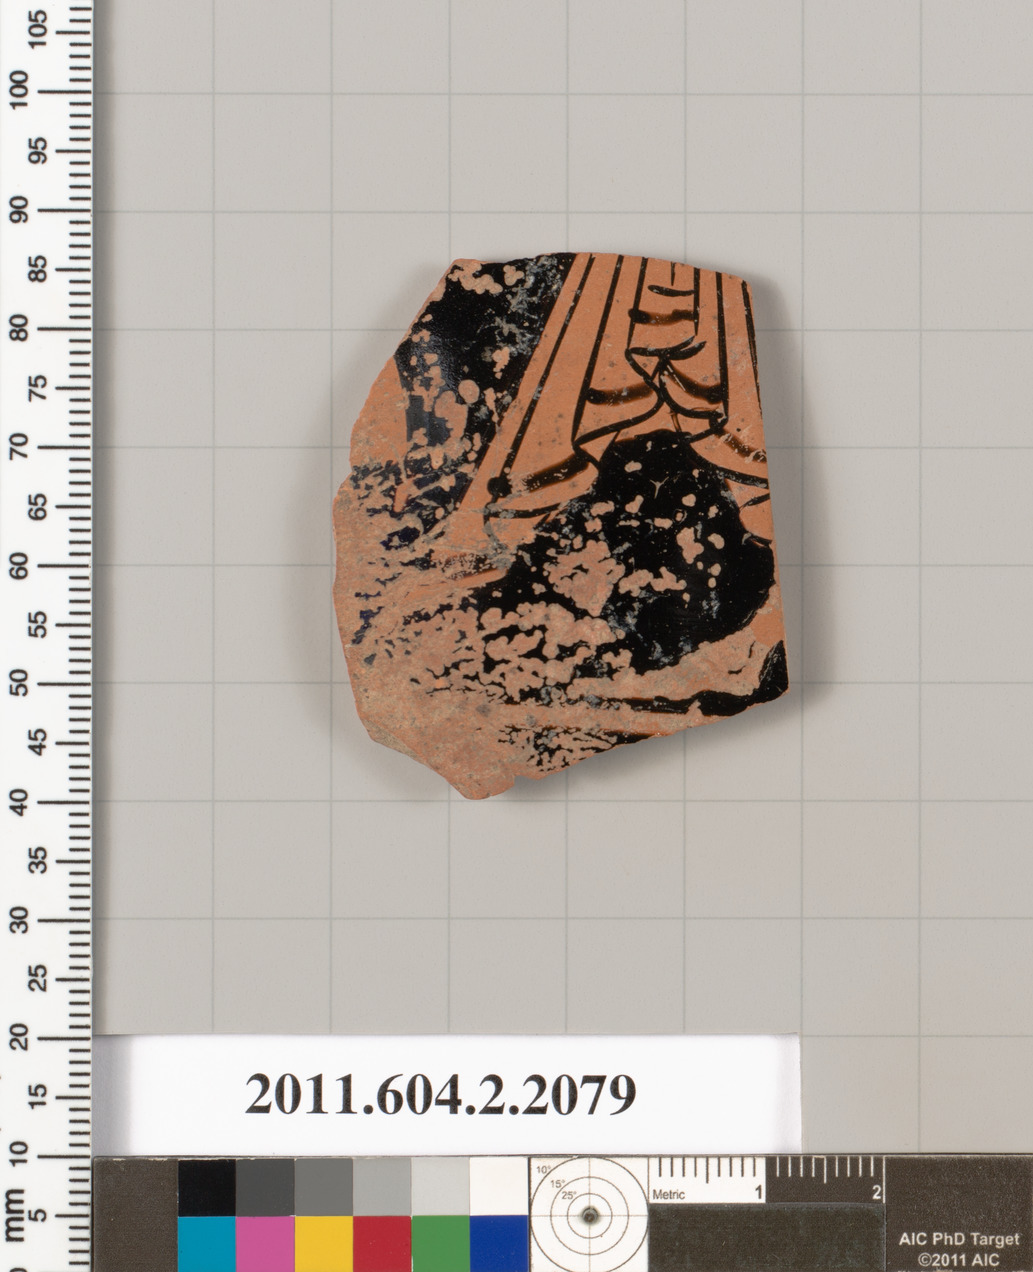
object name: oinochoe fragment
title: Terracotta fragment of an oinochoe (jug)?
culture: greek, attic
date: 500-490 BCE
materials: terracotta